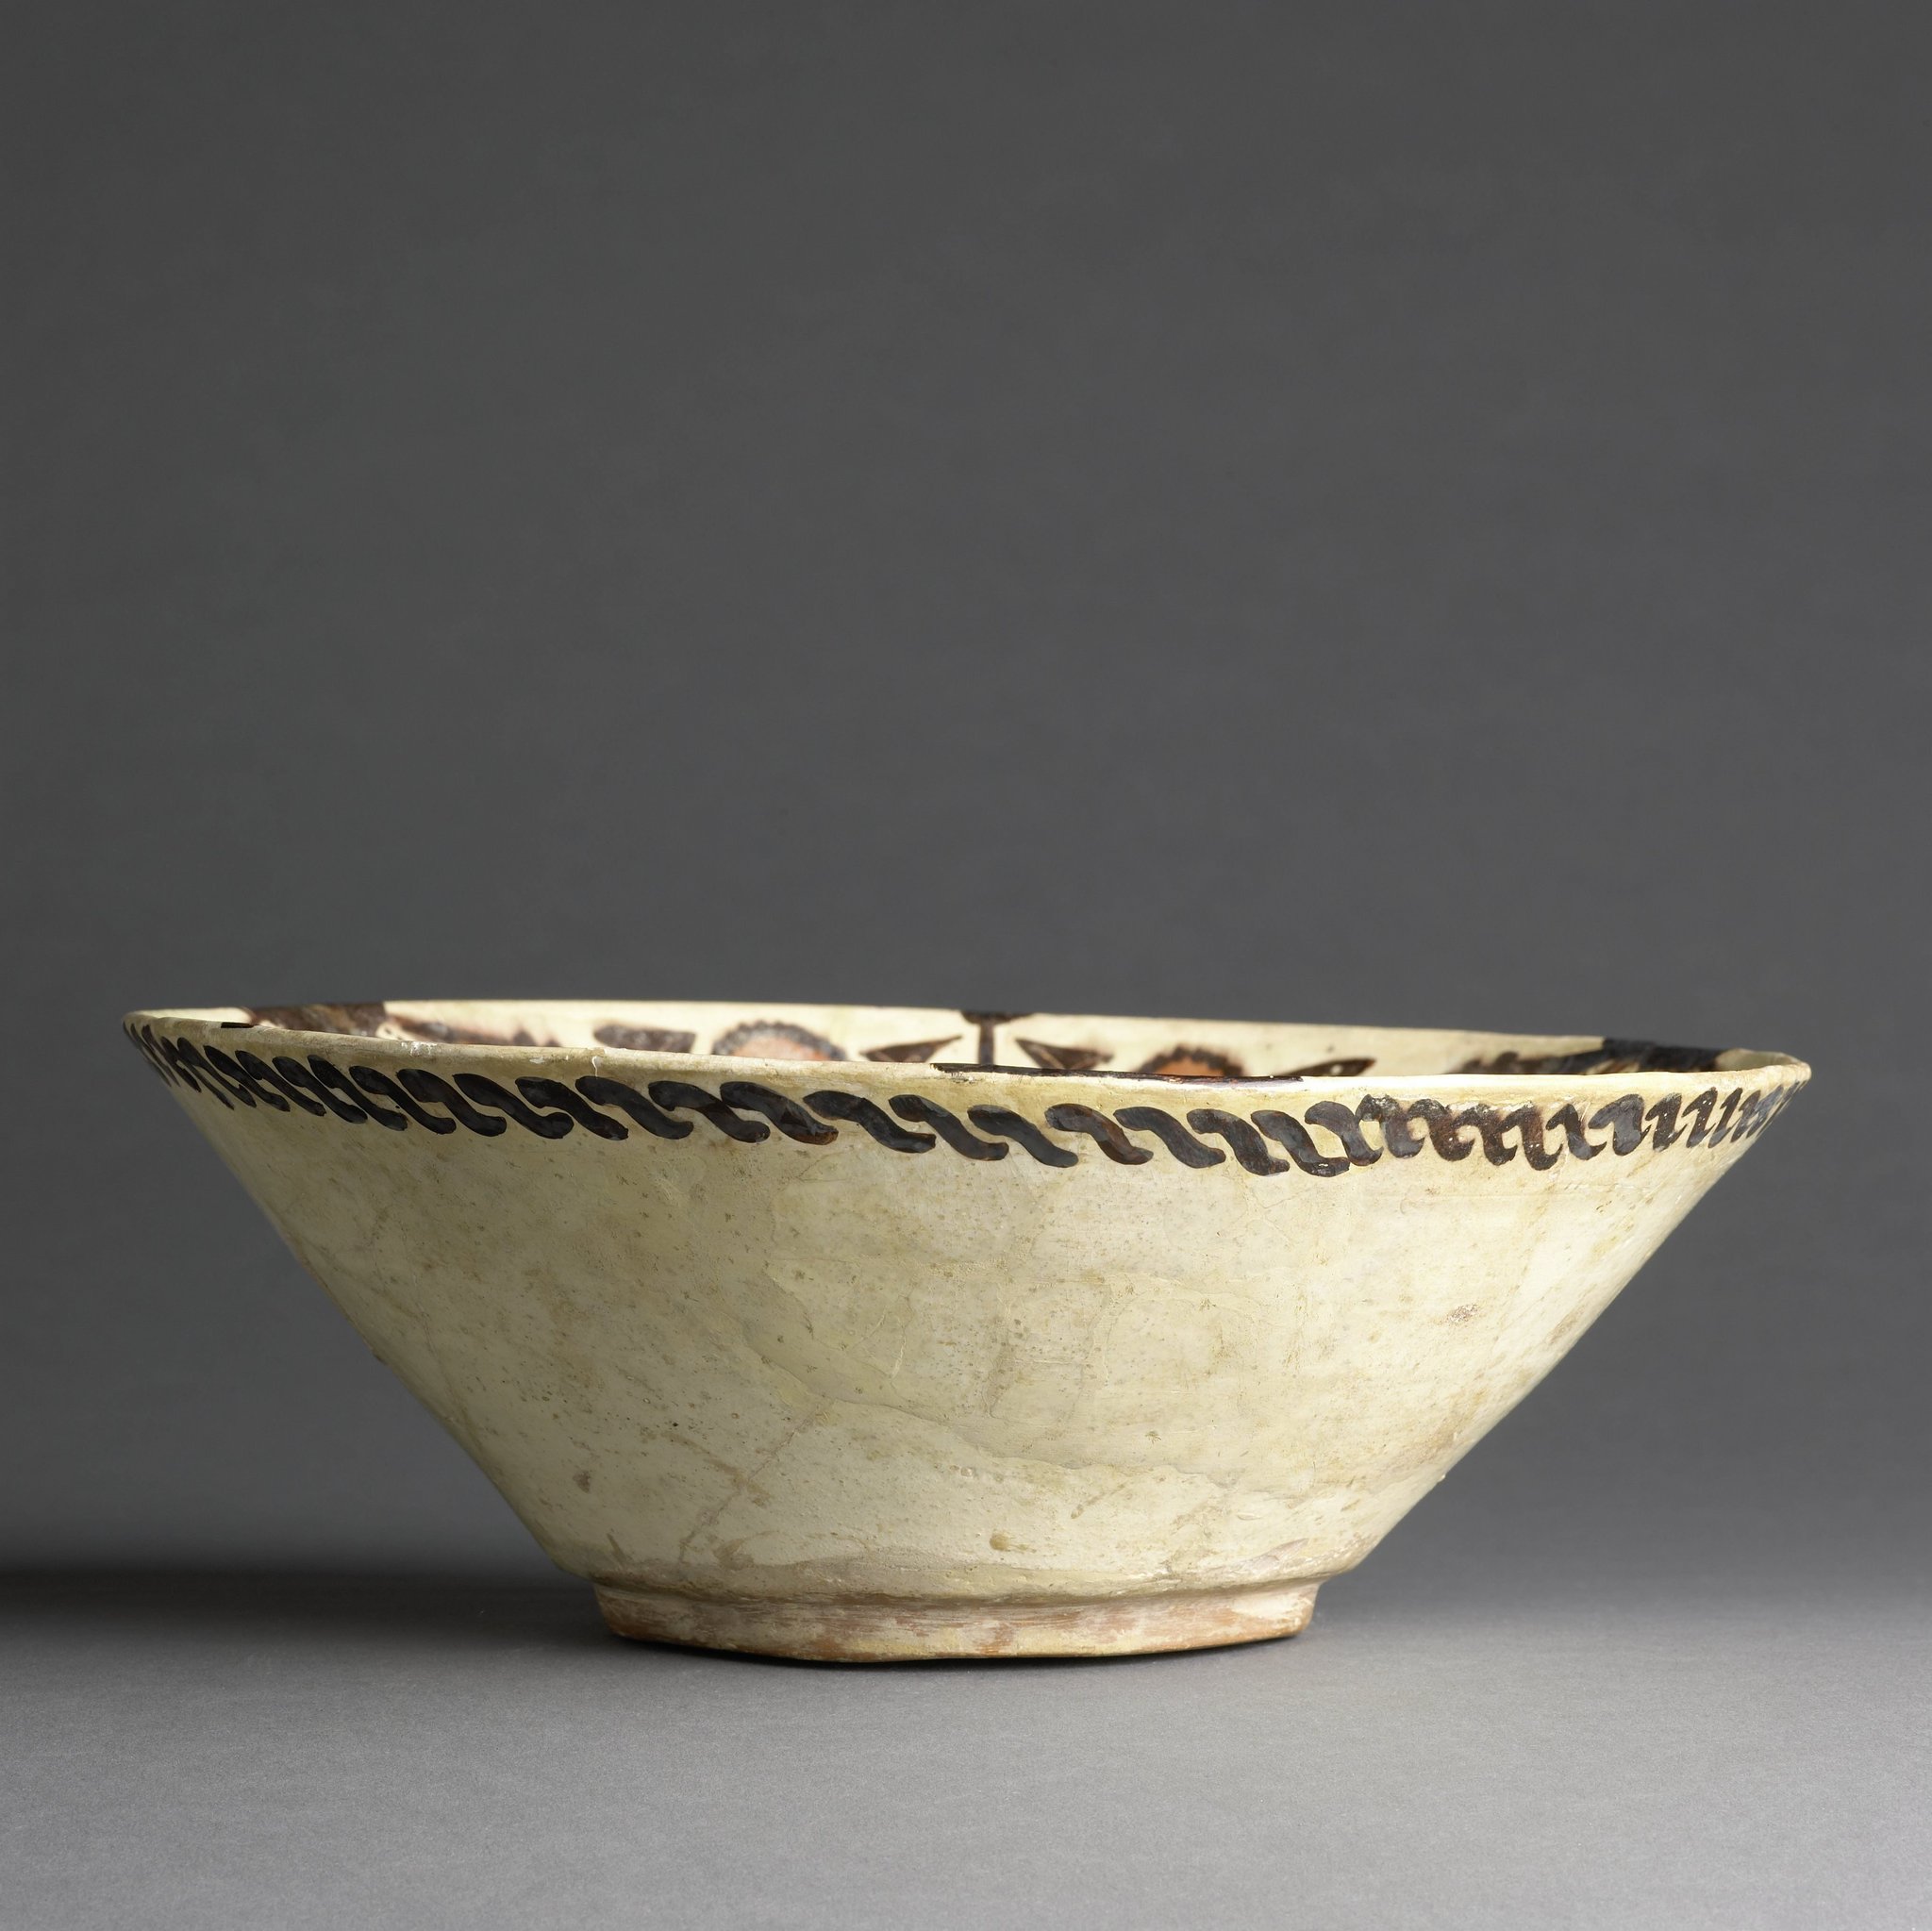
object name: bowl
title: Bowl with stylized flower sprays and (pseudo)-inscription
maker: Anonymous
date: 900-999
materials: earthenware, glaze, paint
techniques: engraving, firing, turning, vitrification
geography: nishapur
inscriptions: : ‘'bismillahi 'r-rahmani 'r-rahim' of een herhaald 'al yoemn' of een herhaald 'barakat'’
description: Bowl. Iran, Nishapur, 10th - 11th century. Earthenware. Given by Prof. Dr J.A. Oosterbaan and Mrs Oosterbaan-Lugt.